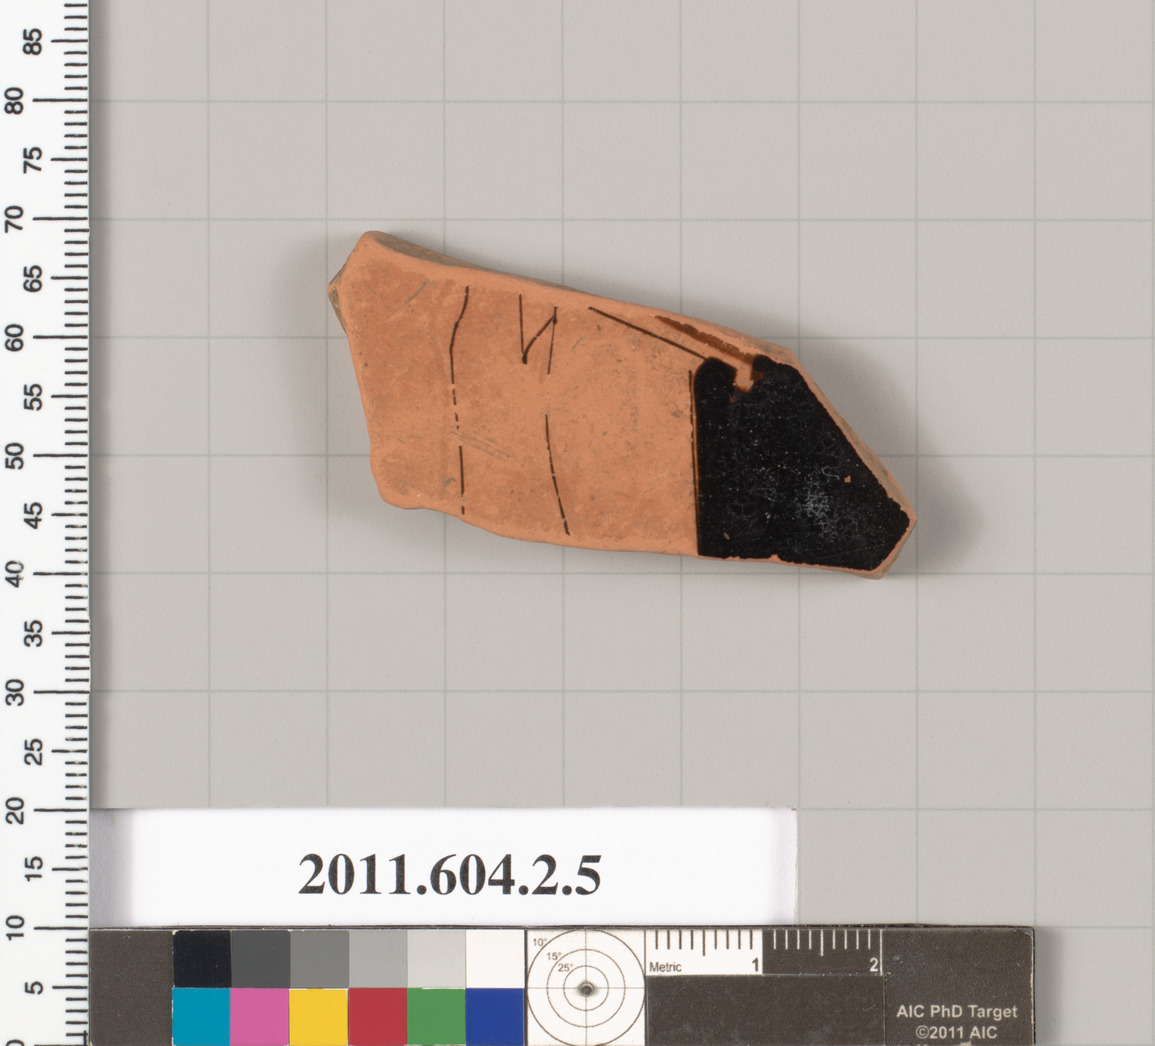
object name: neck amphora fragment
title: Terracotta fragment of a neck-amphora (jar)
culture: greek, attic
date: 475-451 BCE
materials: terracotta